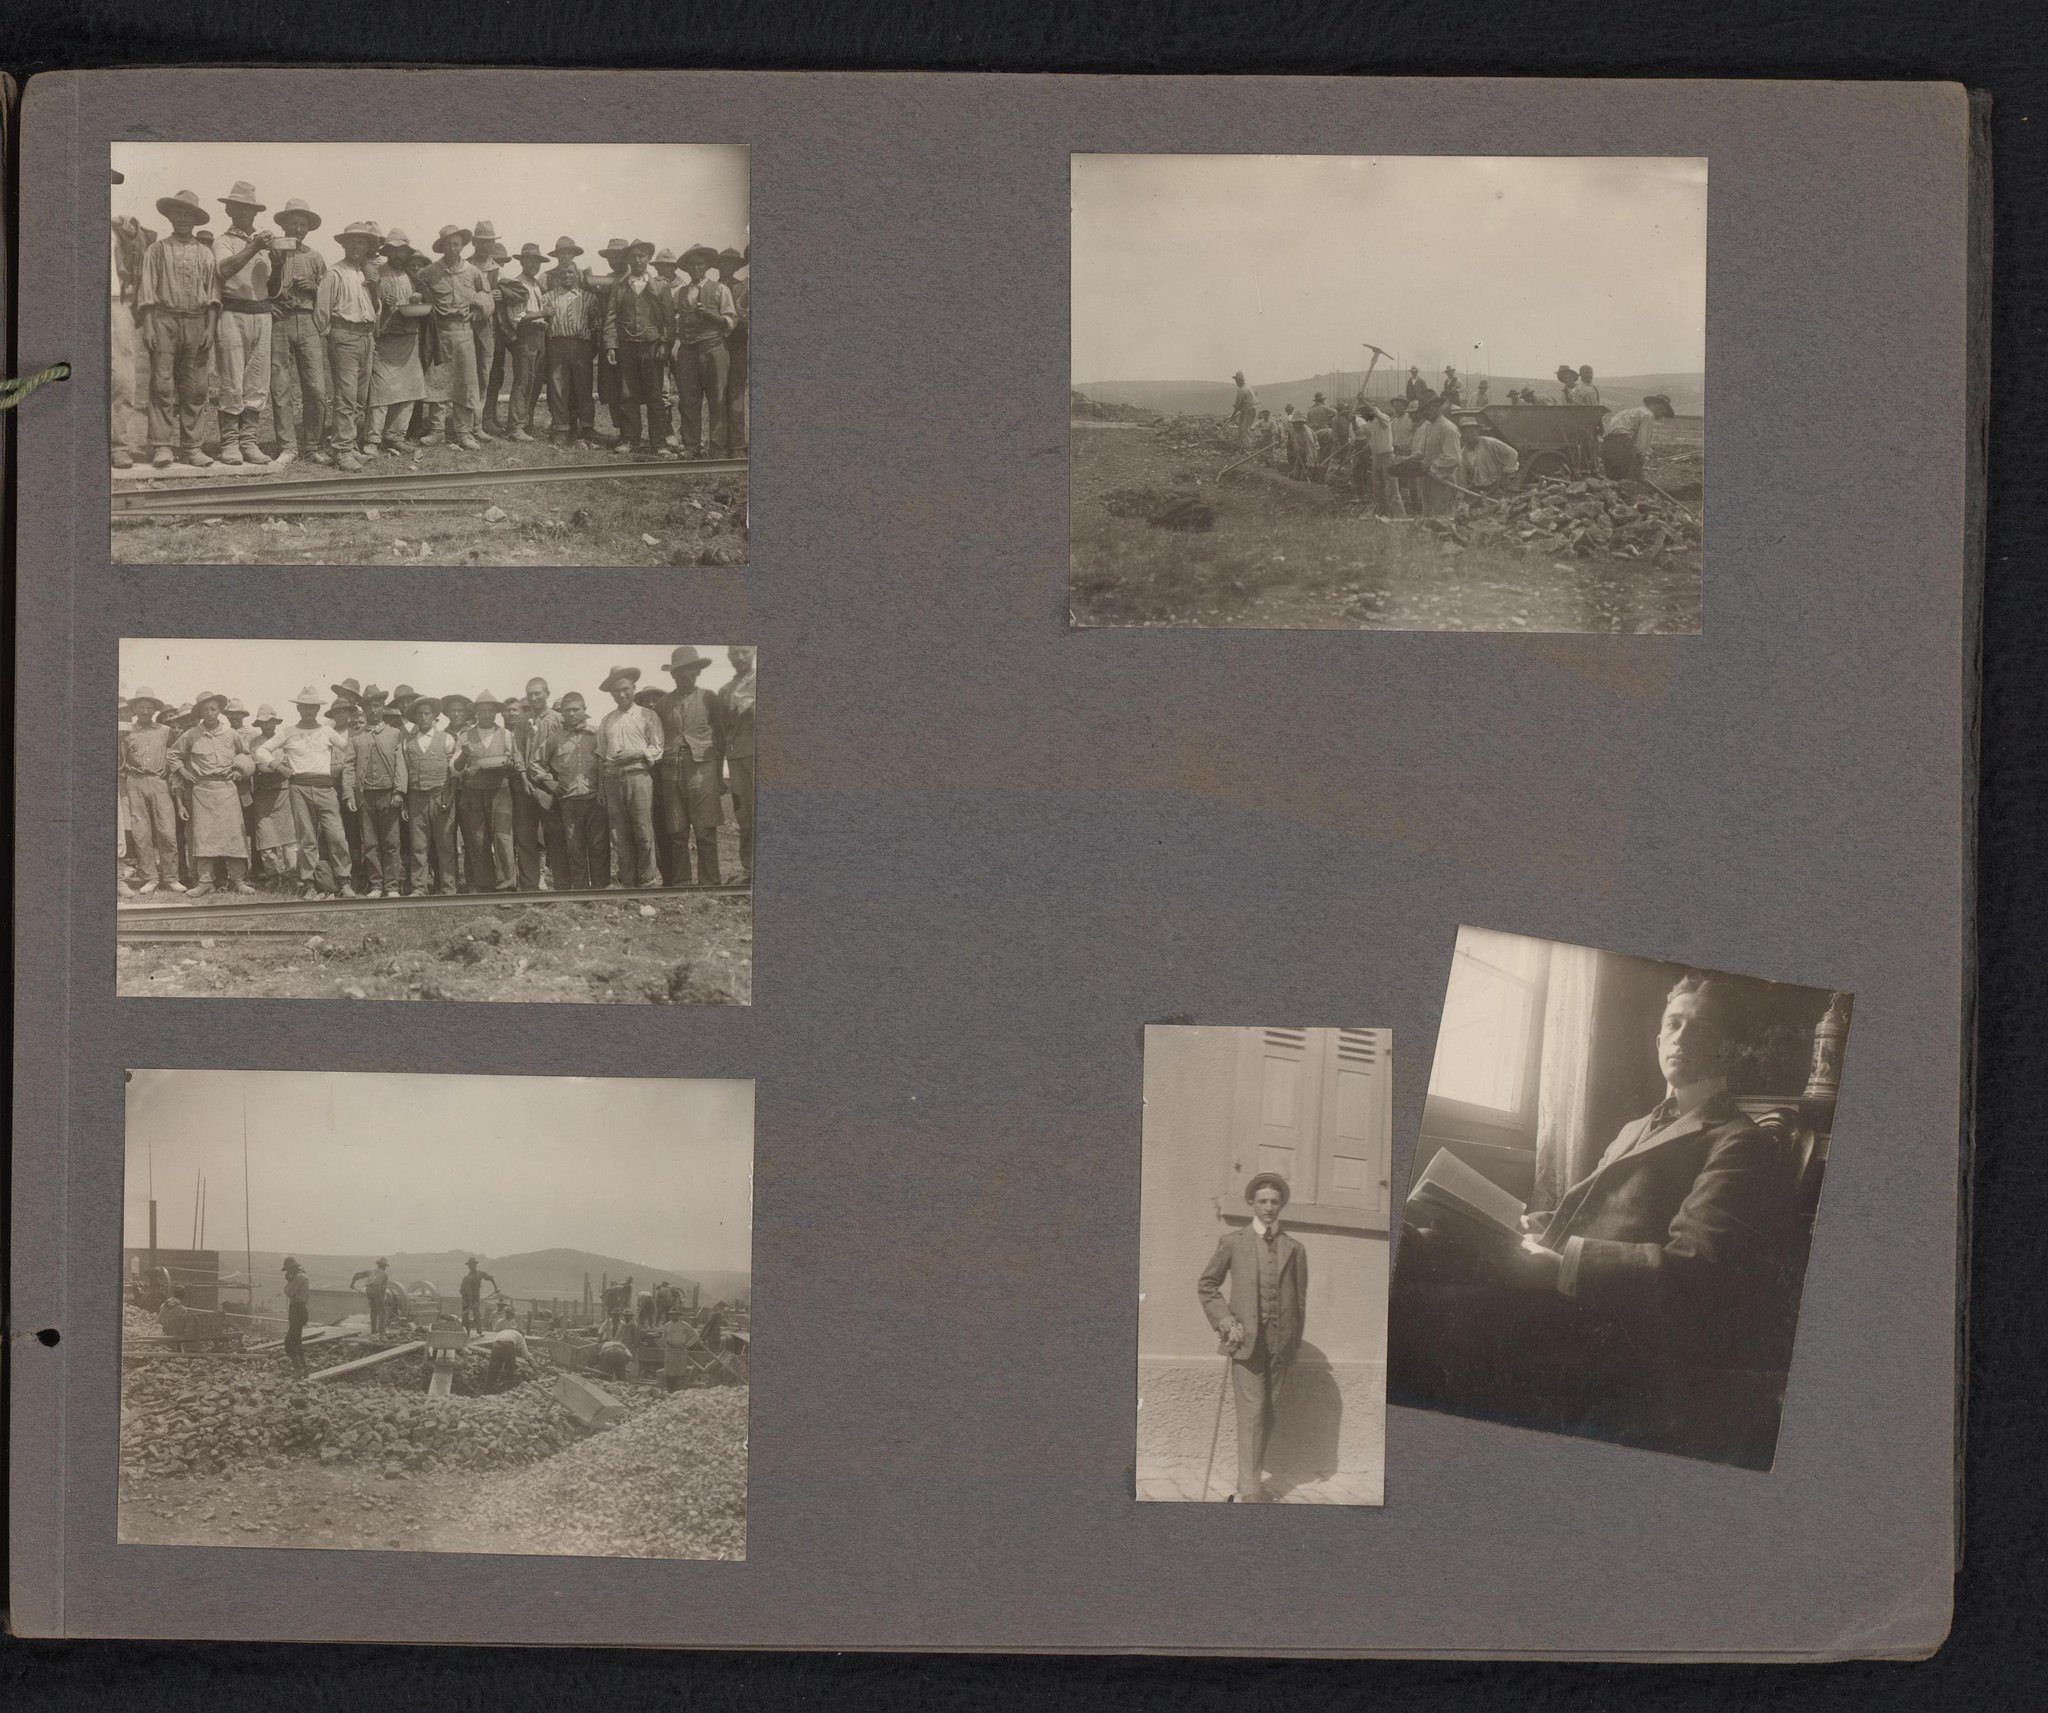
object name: photograph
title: Spoorwegarbeiders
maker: Anonymous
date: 1905-1906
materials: cardboard, photographic support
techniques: gelatin silver print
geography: germany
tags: arthur moos, digging (industrial process) (+ men (labourers)), historical persons, railway, train, anonymous historical persons portrayed in a group, in a group-portrait, germany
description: Albumblad met zes foto's van spoorwegarbeiders die als groep poseren en tijdens het werk, plus twee kleinere portretten van een man, waarschijnlijk Arthur Moos. Onderdeel van het fotoalbum van Arthur Moos tijdens zijn militaire diensttijd bij het 20e regiment Ulanen, Ludwigsburg, 1905-1906.